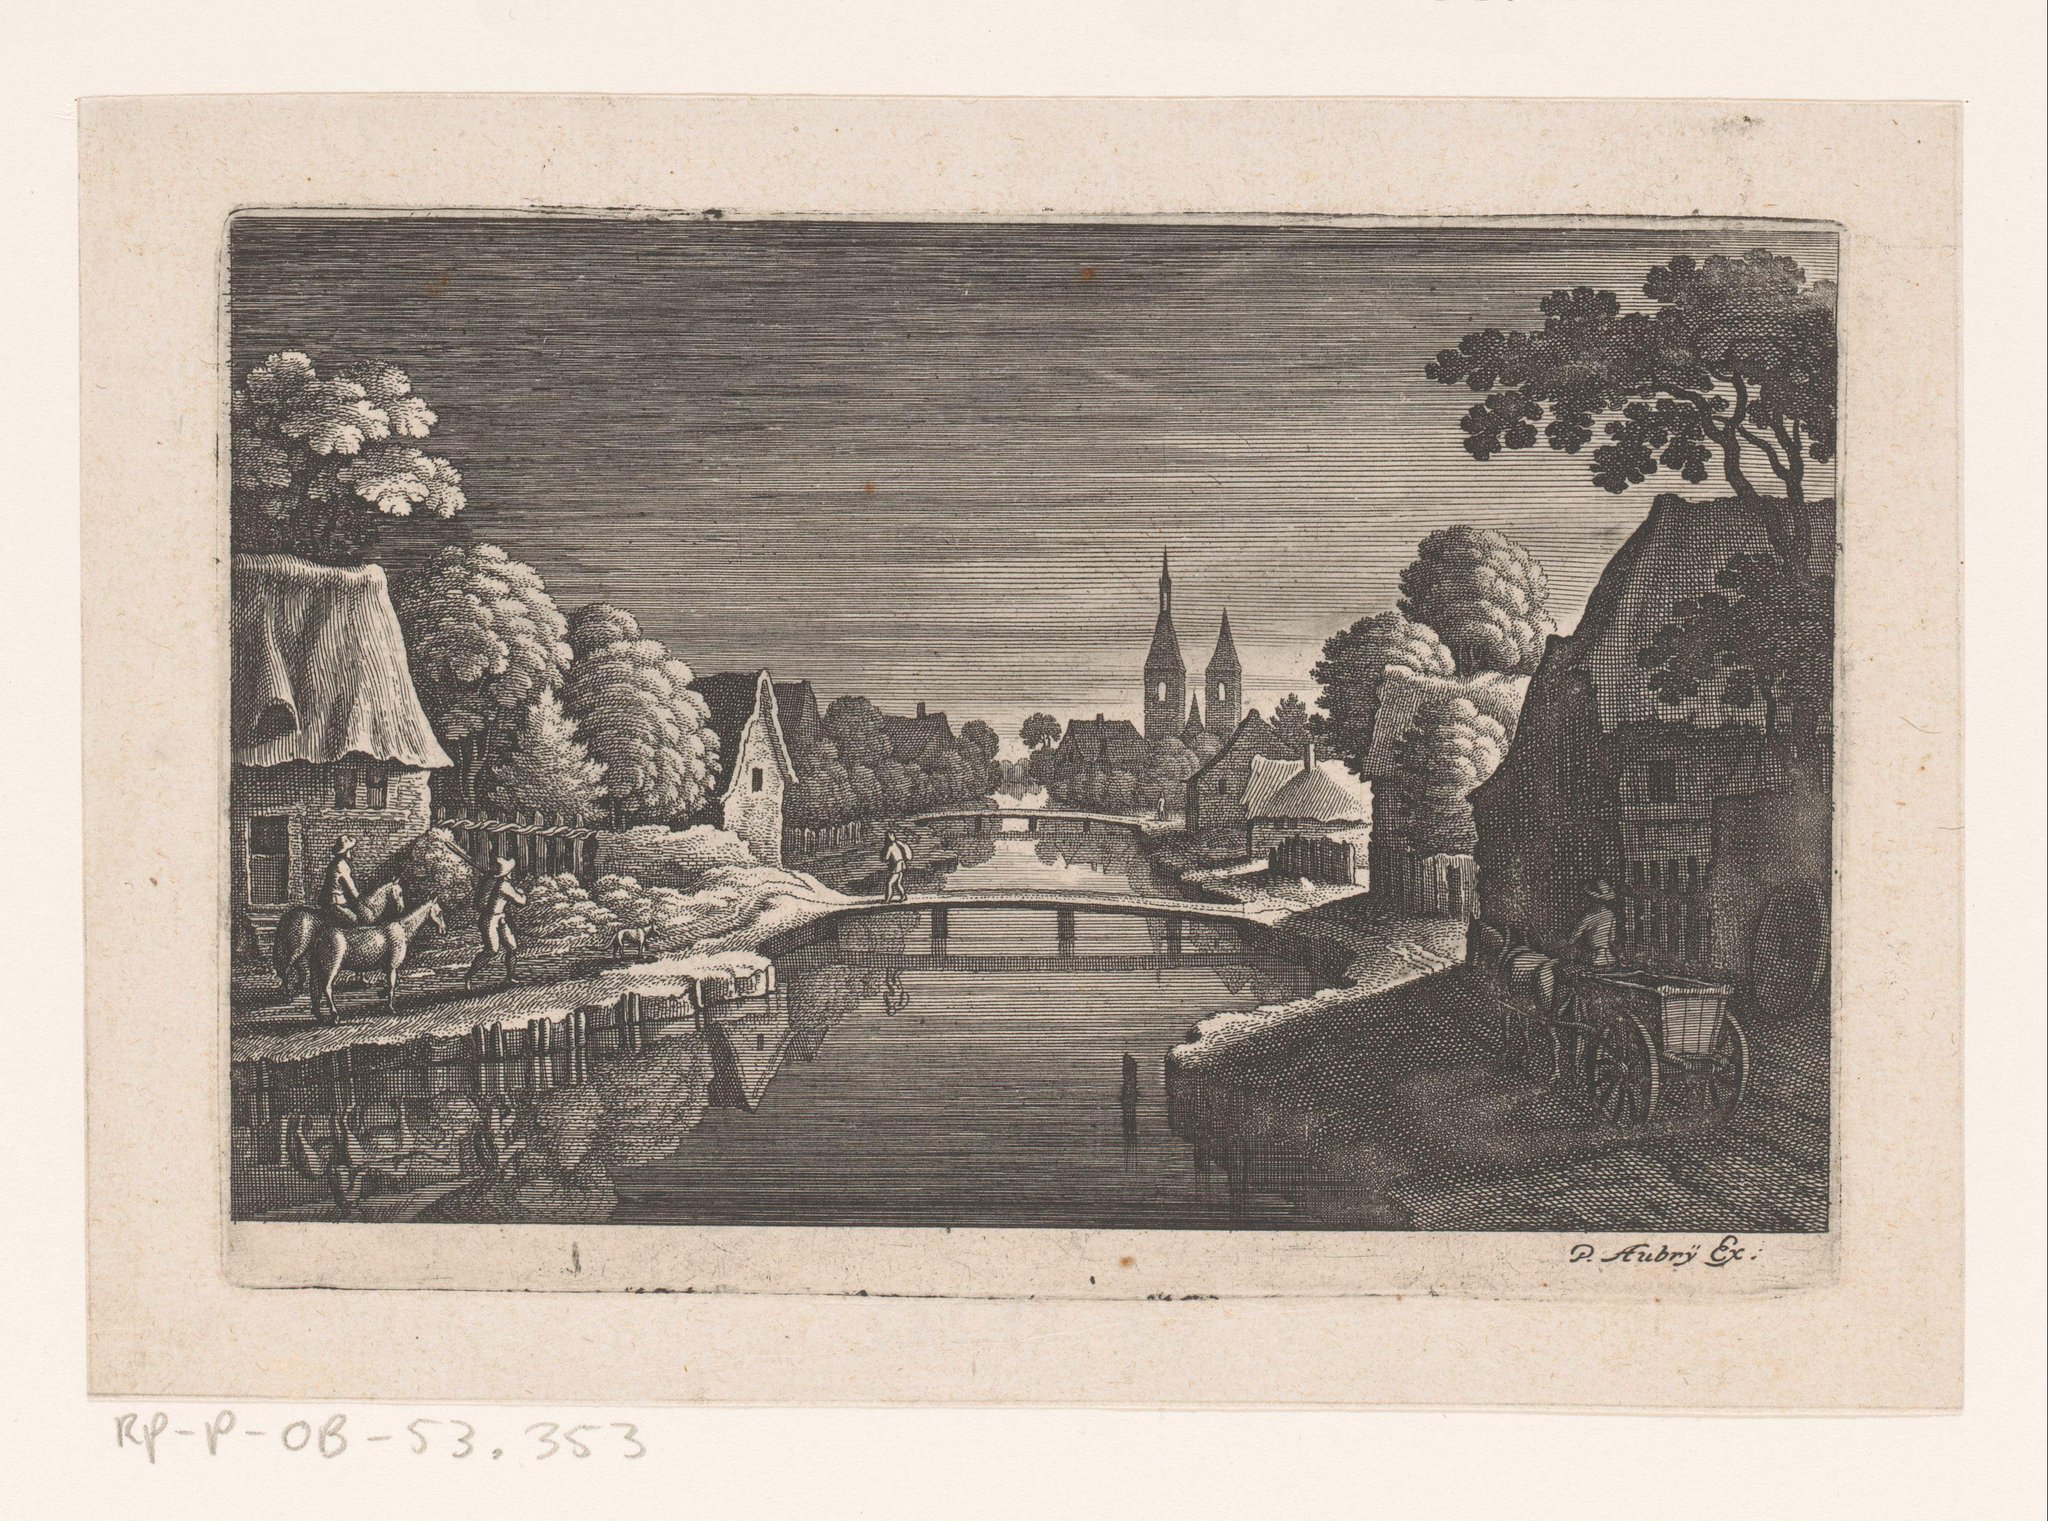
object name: print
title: Dorp bij nacht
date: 1603-1650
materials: paper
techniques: etching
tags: village, night, (farm) wagon, freight wagon, cart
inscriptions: collector's mark: Lugt 240, collector's mark: Lugt 1838